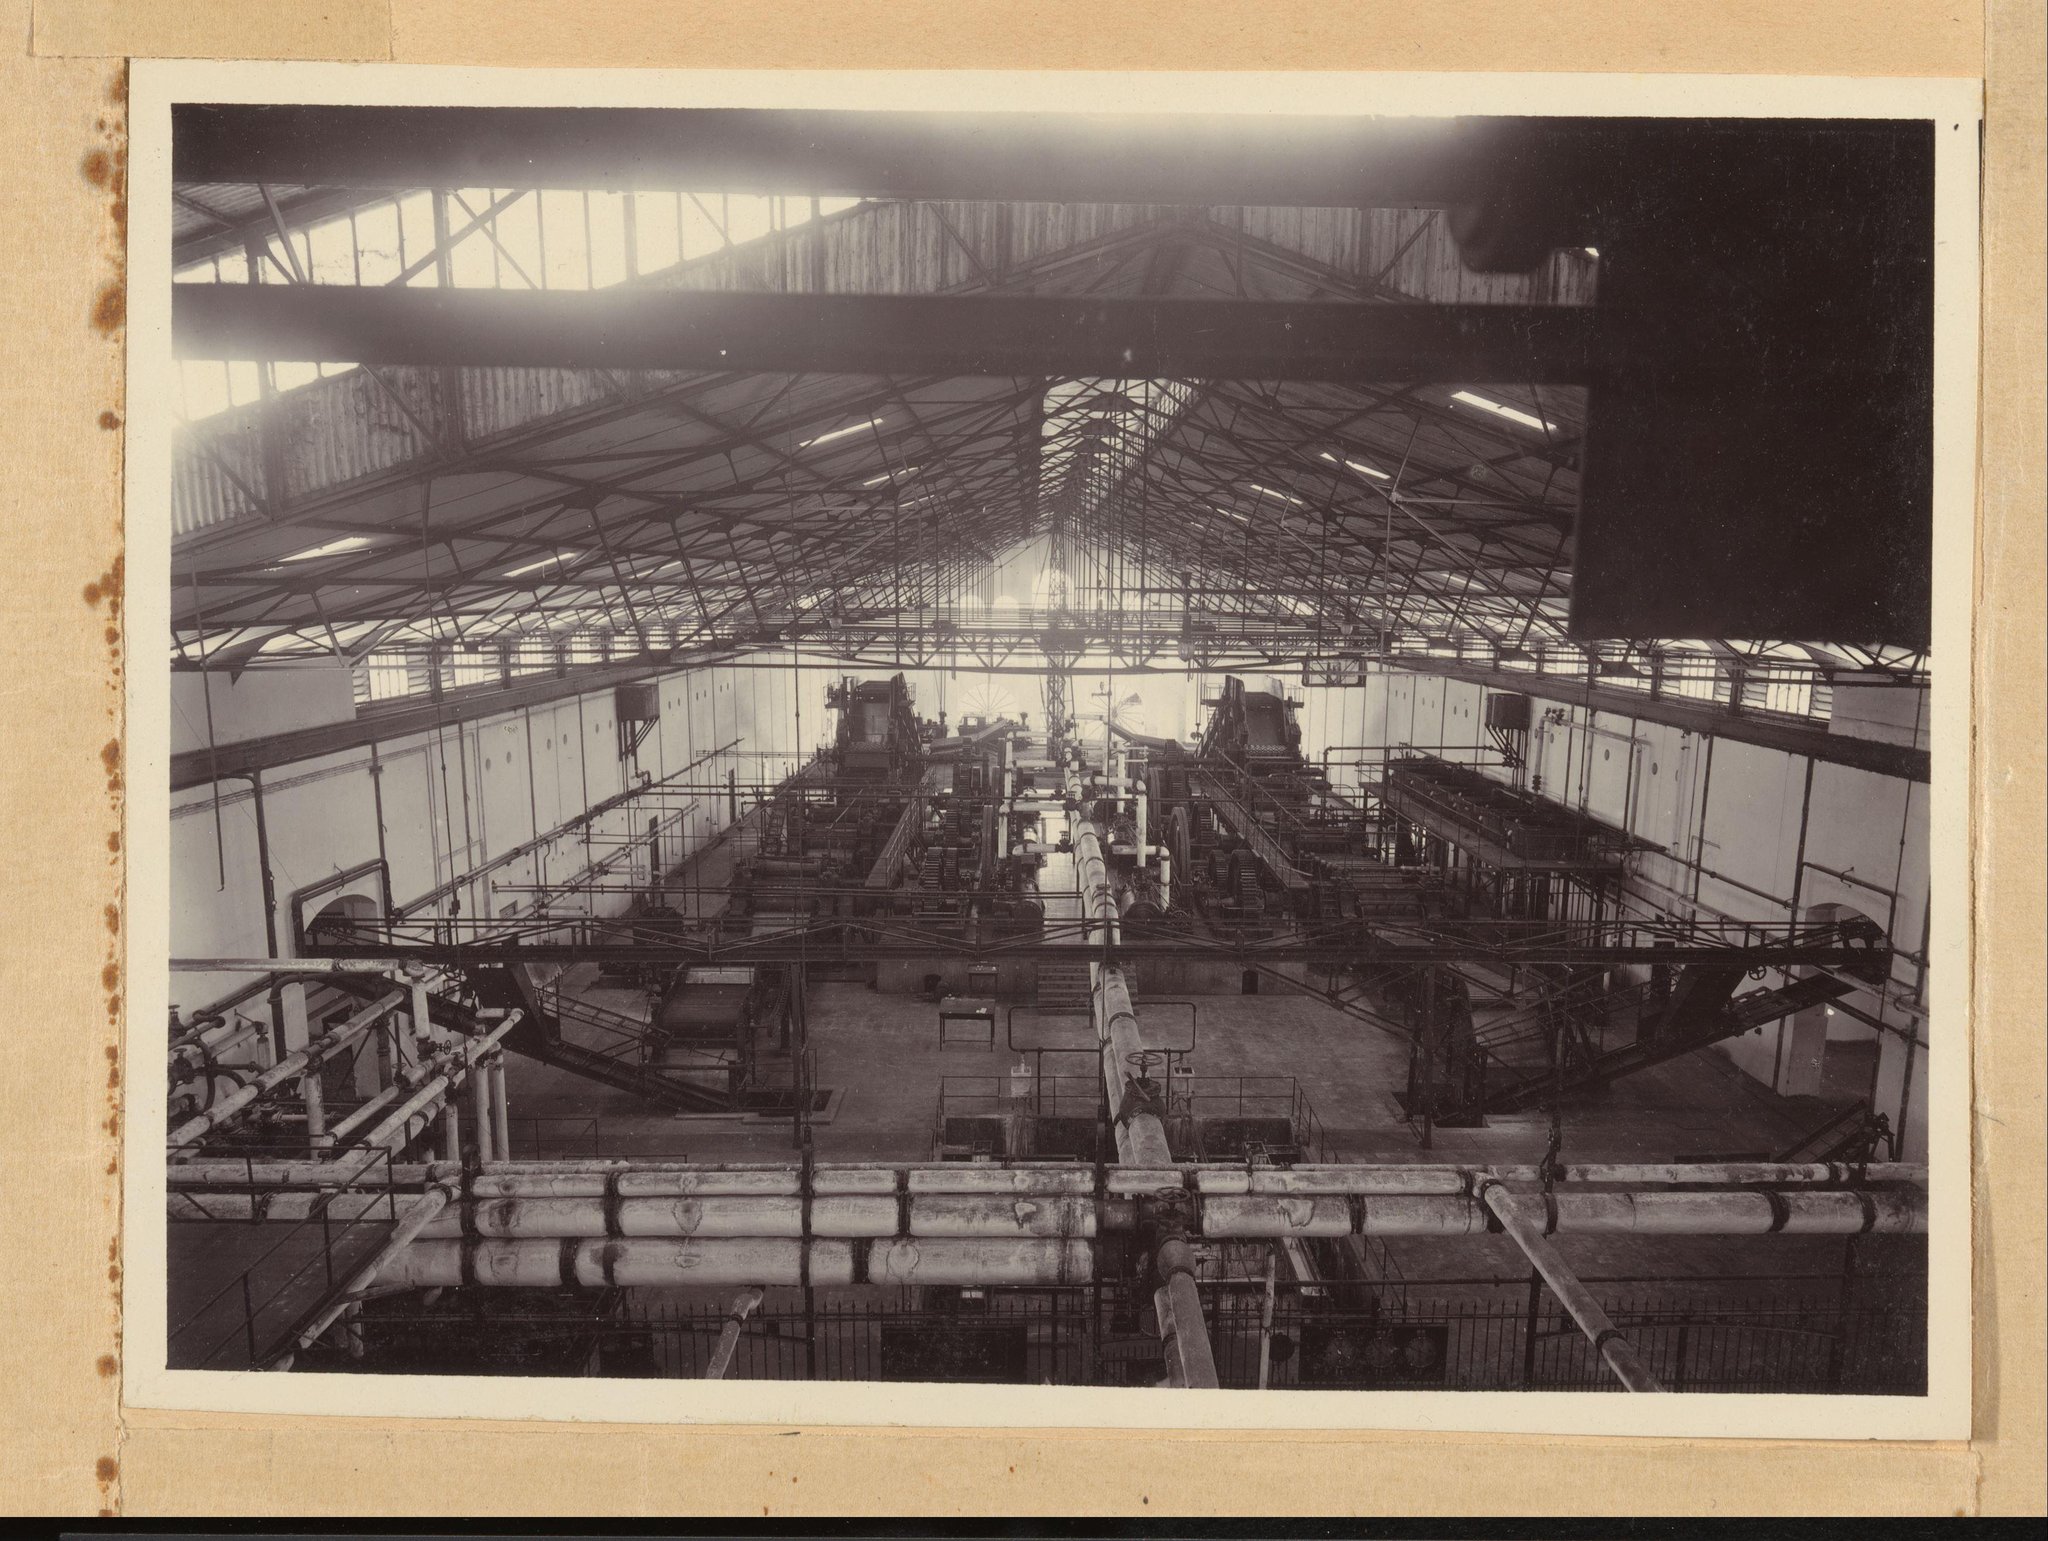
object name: photograph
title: Fabriekshal, vermoedelijk interieur van een suikerfabriek in Purworejo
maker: Anonymous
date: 1916-1918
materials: photographic support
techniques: gelatin silver print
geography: purworejo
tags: factory-interior, machine shop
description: Onderdeel van Familiealbum met foto's van een familie in de voormalige kolonie Nederlands-Indië en van een suikerfabriek in Purworejo.